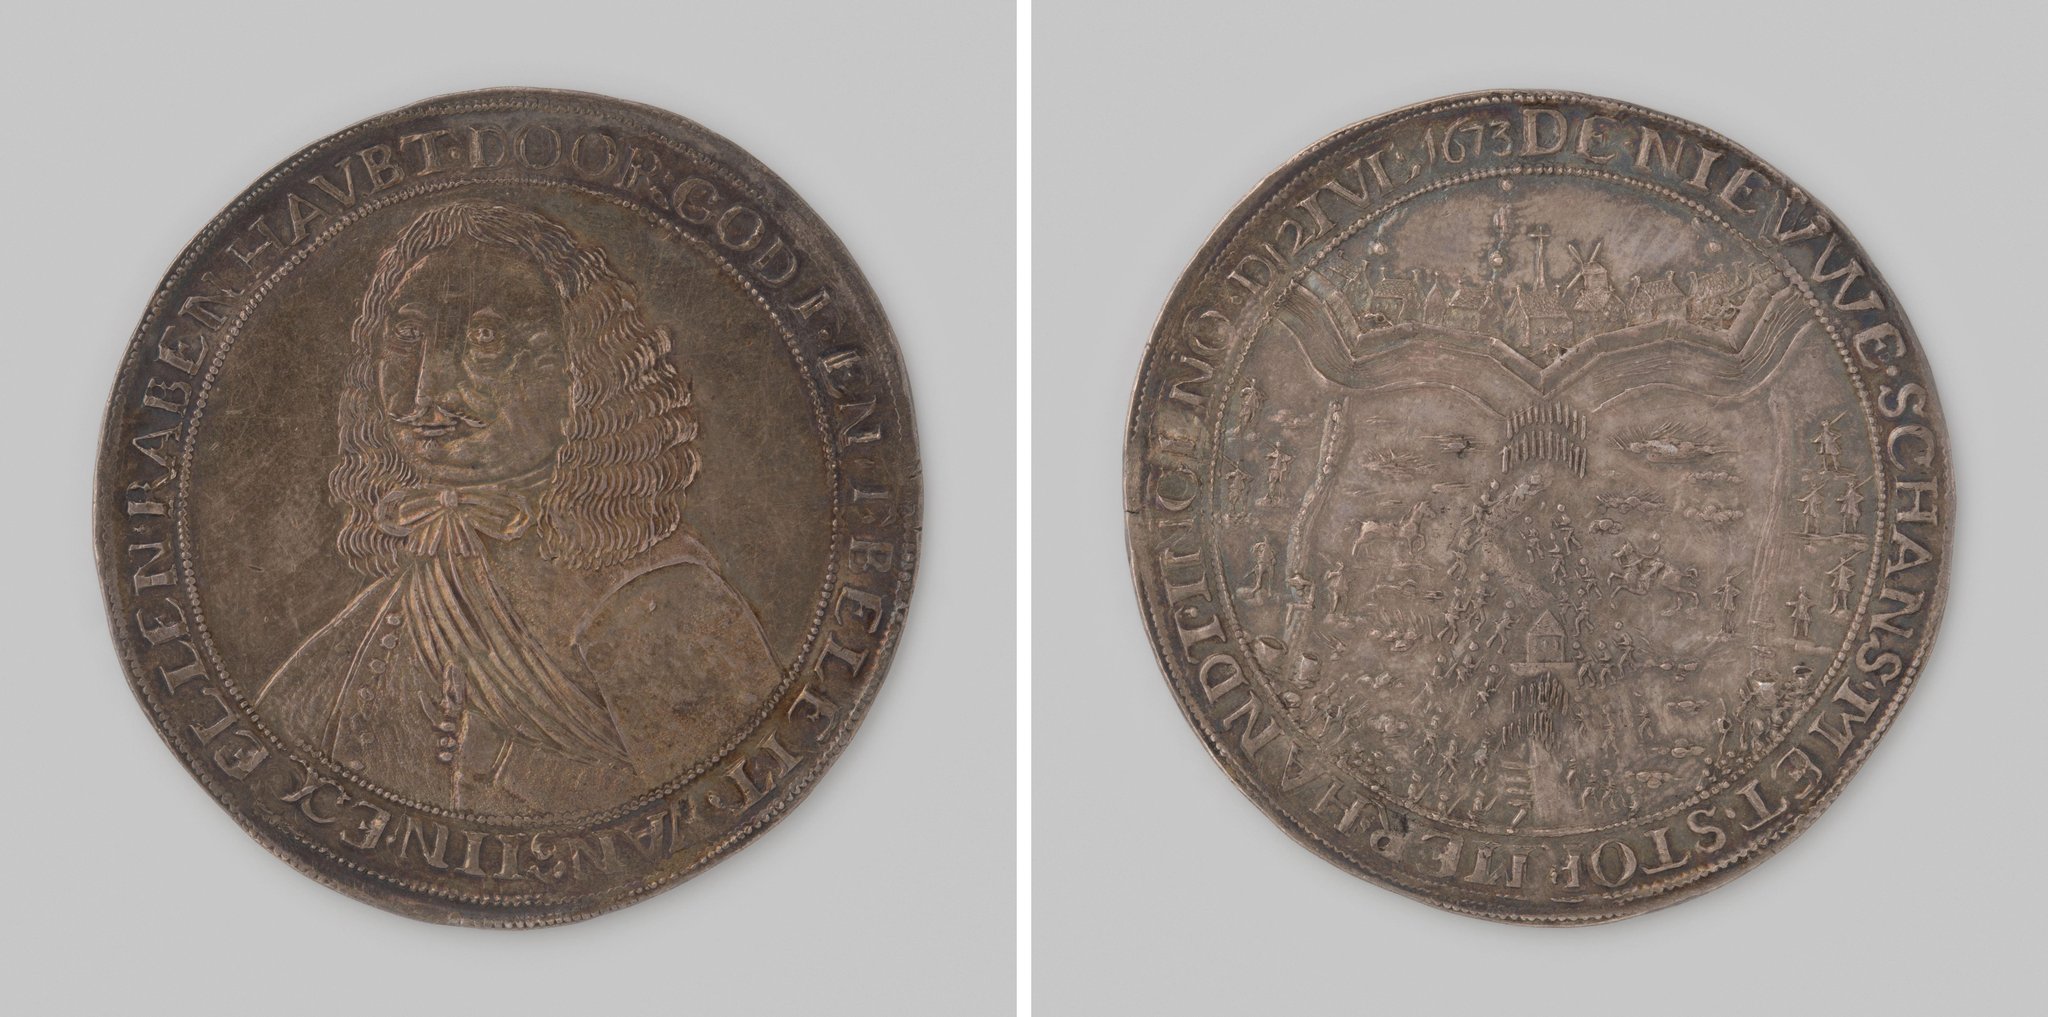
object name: history medal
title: Inname van Nieuweschans door Rabenhaupt 1673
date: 1673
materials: silver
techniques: striking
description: Zilveren penning, op de voorzijde het portret van Rabenhaupt half naar links, met omschrift, op de keerzijde het aanzicht van Nieuweschans met daarvoor in vogelvlucht de aanvallende soldaten, met omschrift.